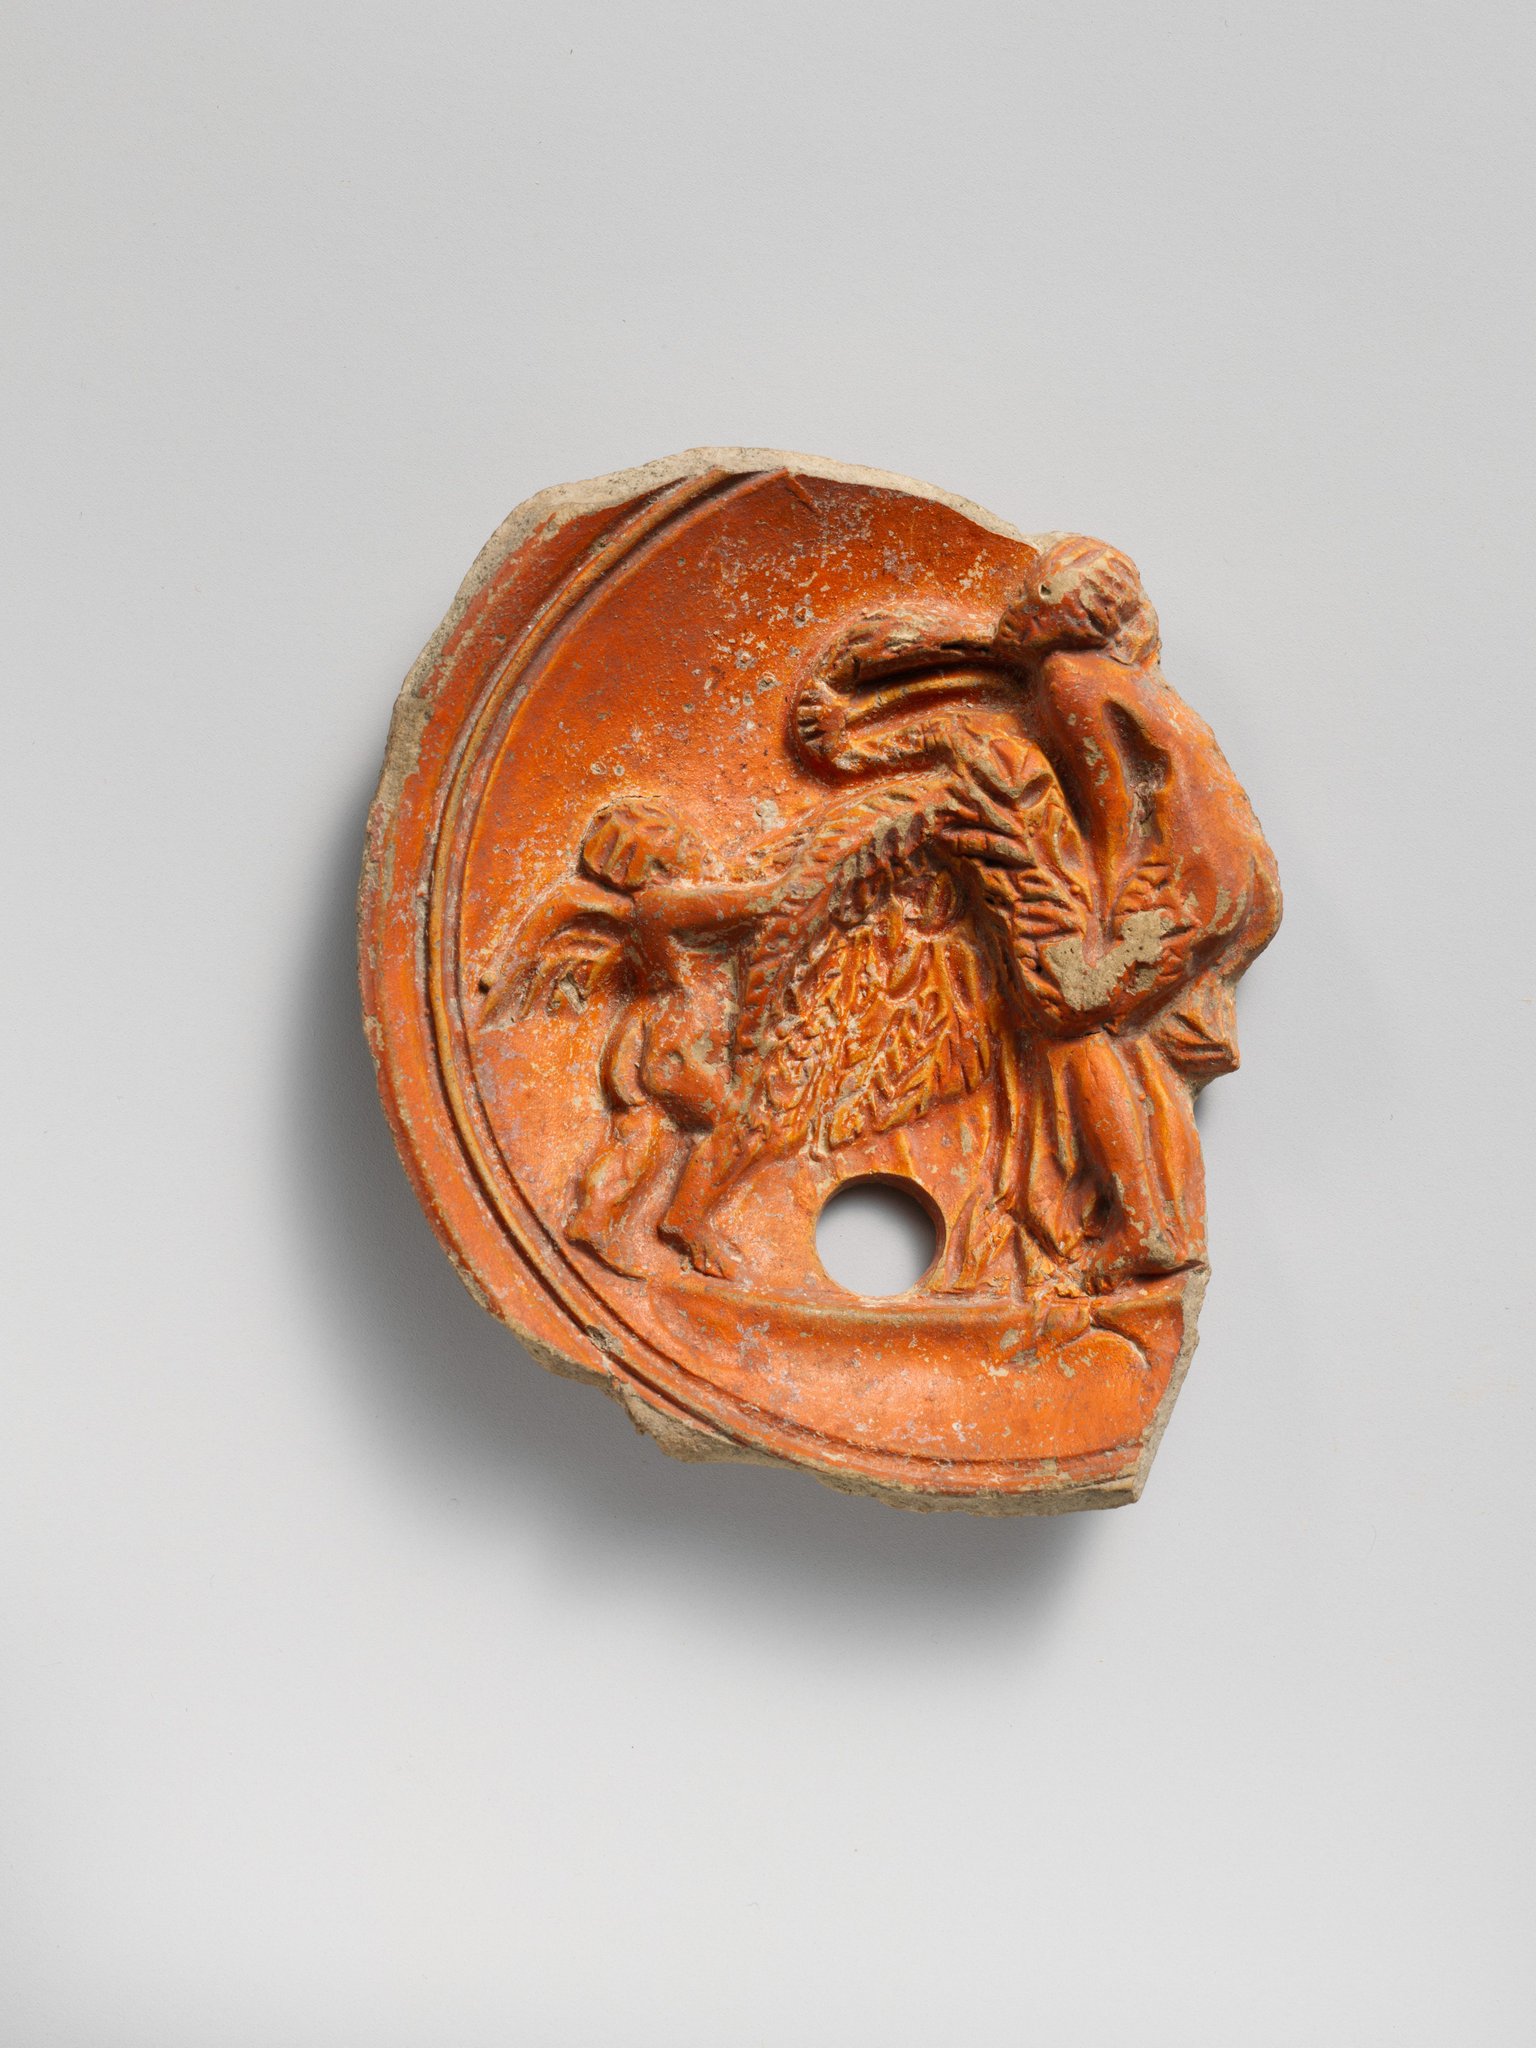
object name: lamp relief fragment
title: Terracotta relief from a lamp with Leda and the swan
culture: roman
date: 31-330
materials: terracotta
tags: leda,swans